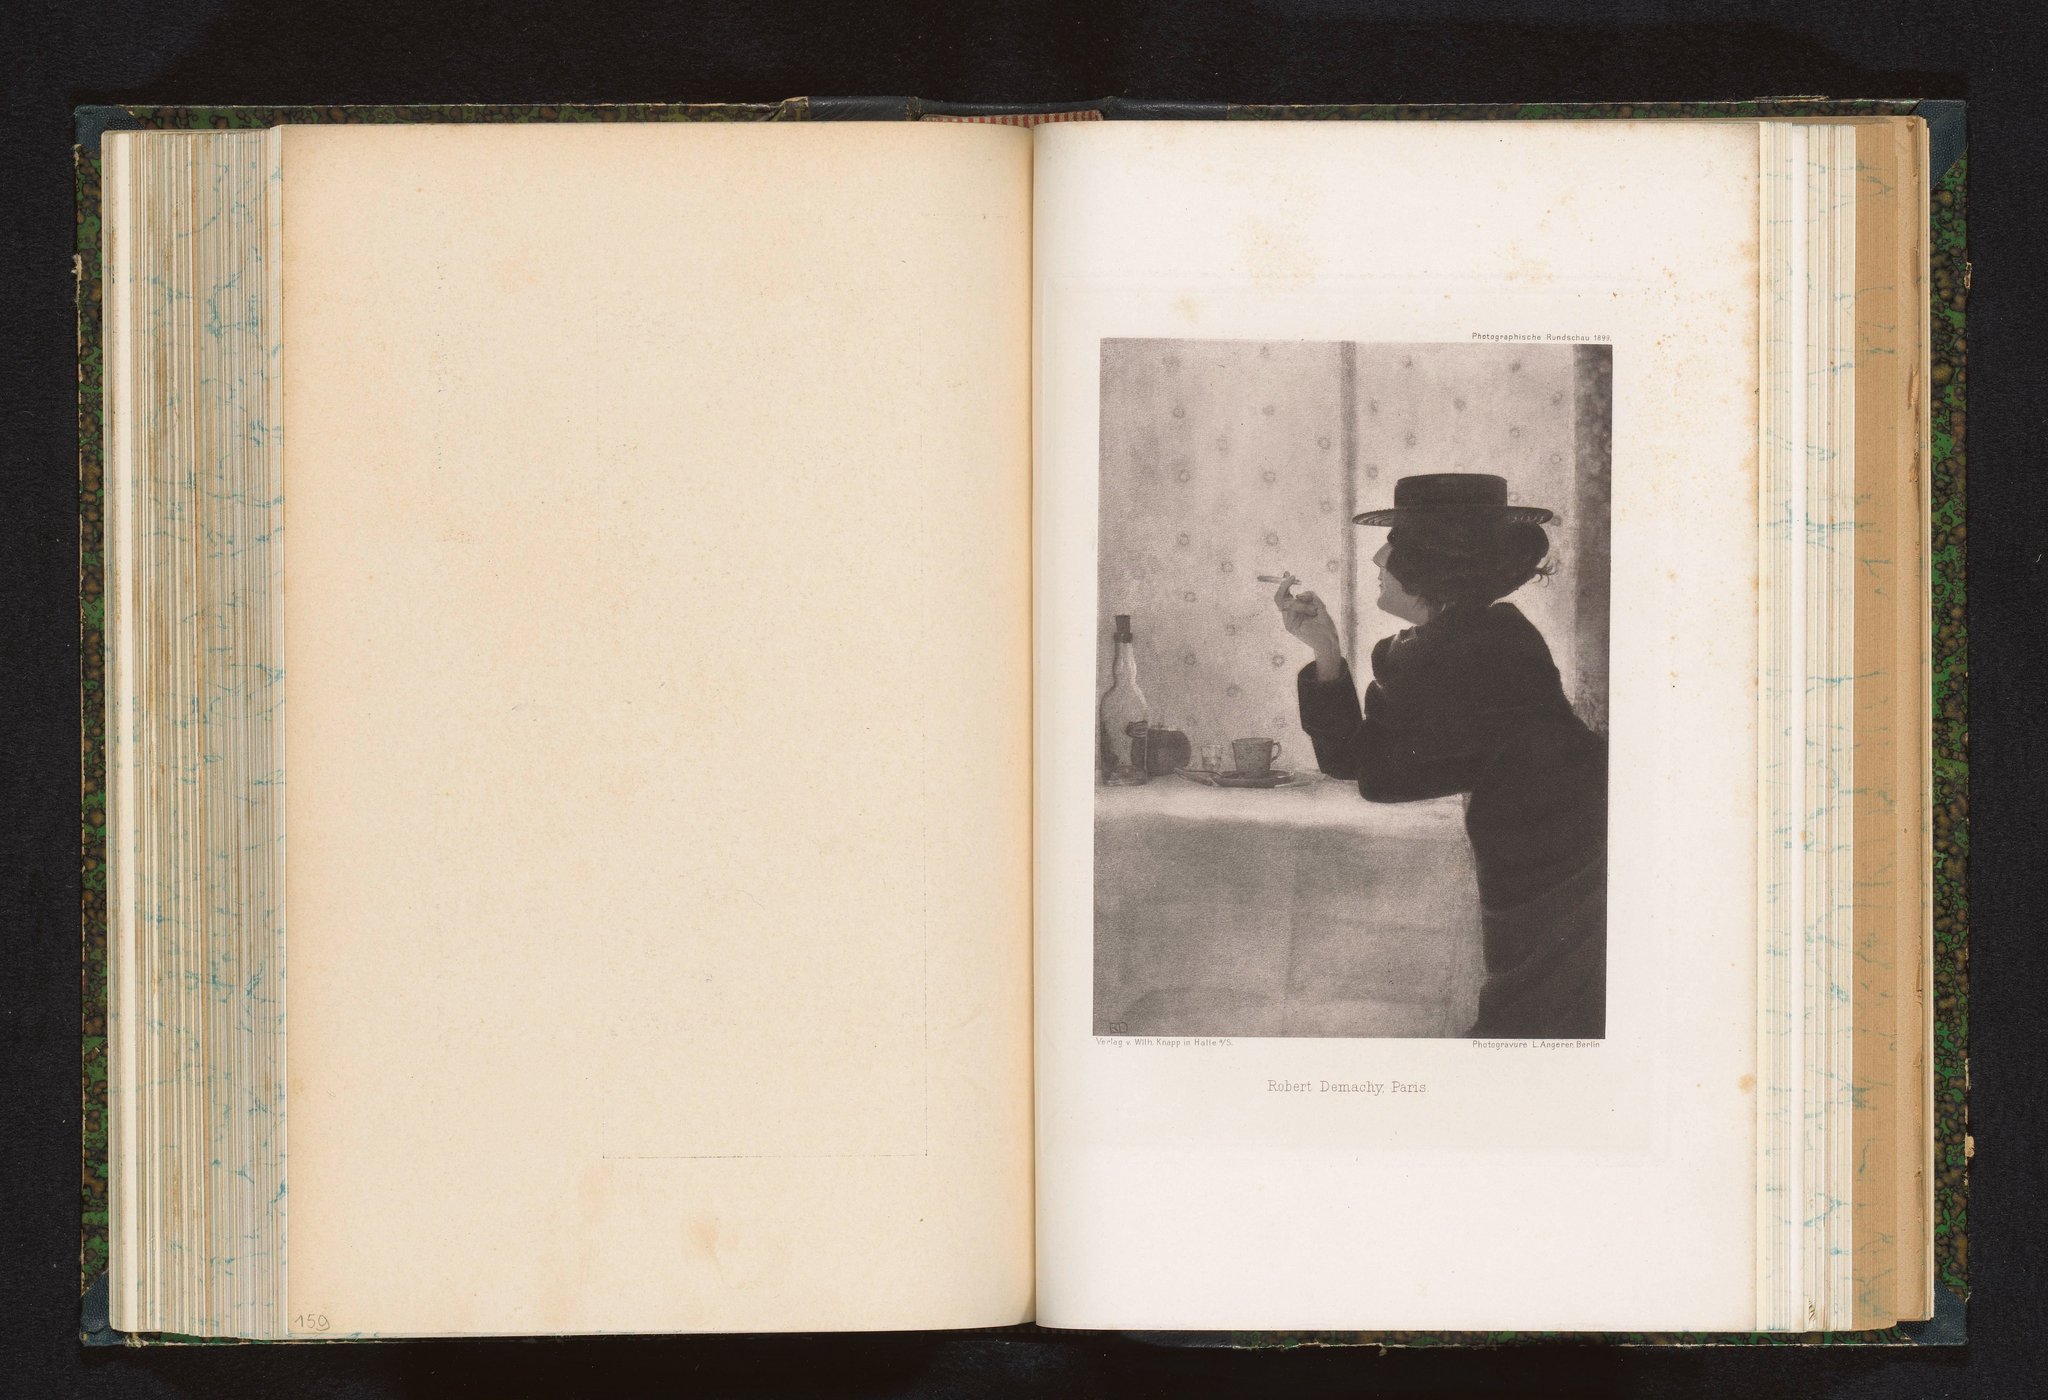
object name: photomechanical print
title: Portret van een onbekende vrouw met sigaret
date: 1894-1899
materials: paper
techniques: photoaquatint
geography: halle an der saale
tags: cigarette, historical persons not known by name - bb - woman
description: Prent op tweede ongenummerde pagina na pagina 296.